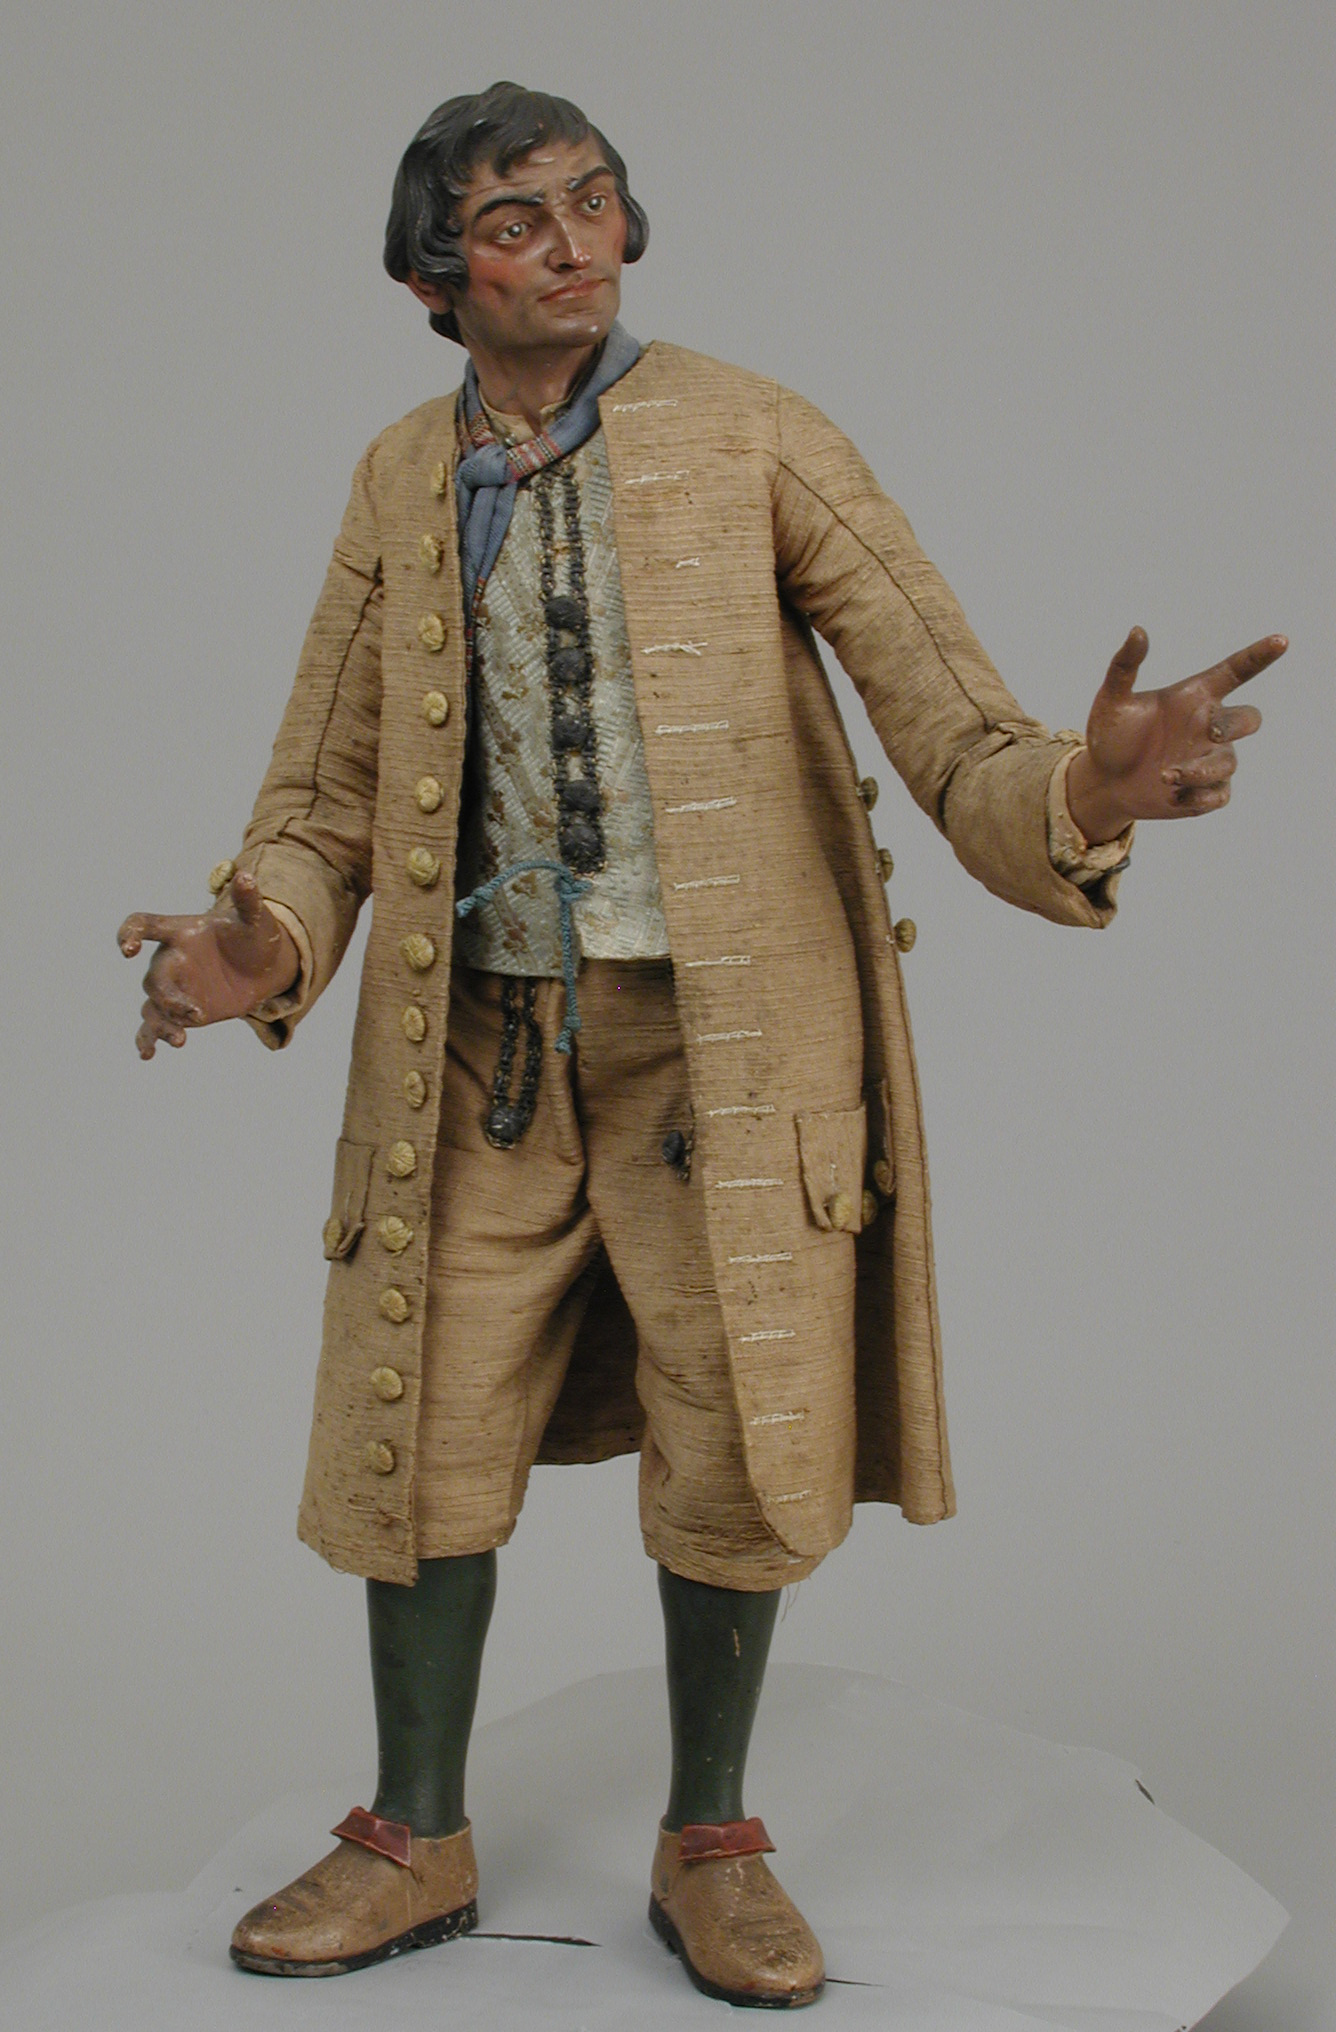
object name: crèche figure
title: Man with walking stick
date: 1767-1833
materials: metal, silk, fiber, terracotta, wood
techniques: polychrome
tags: men